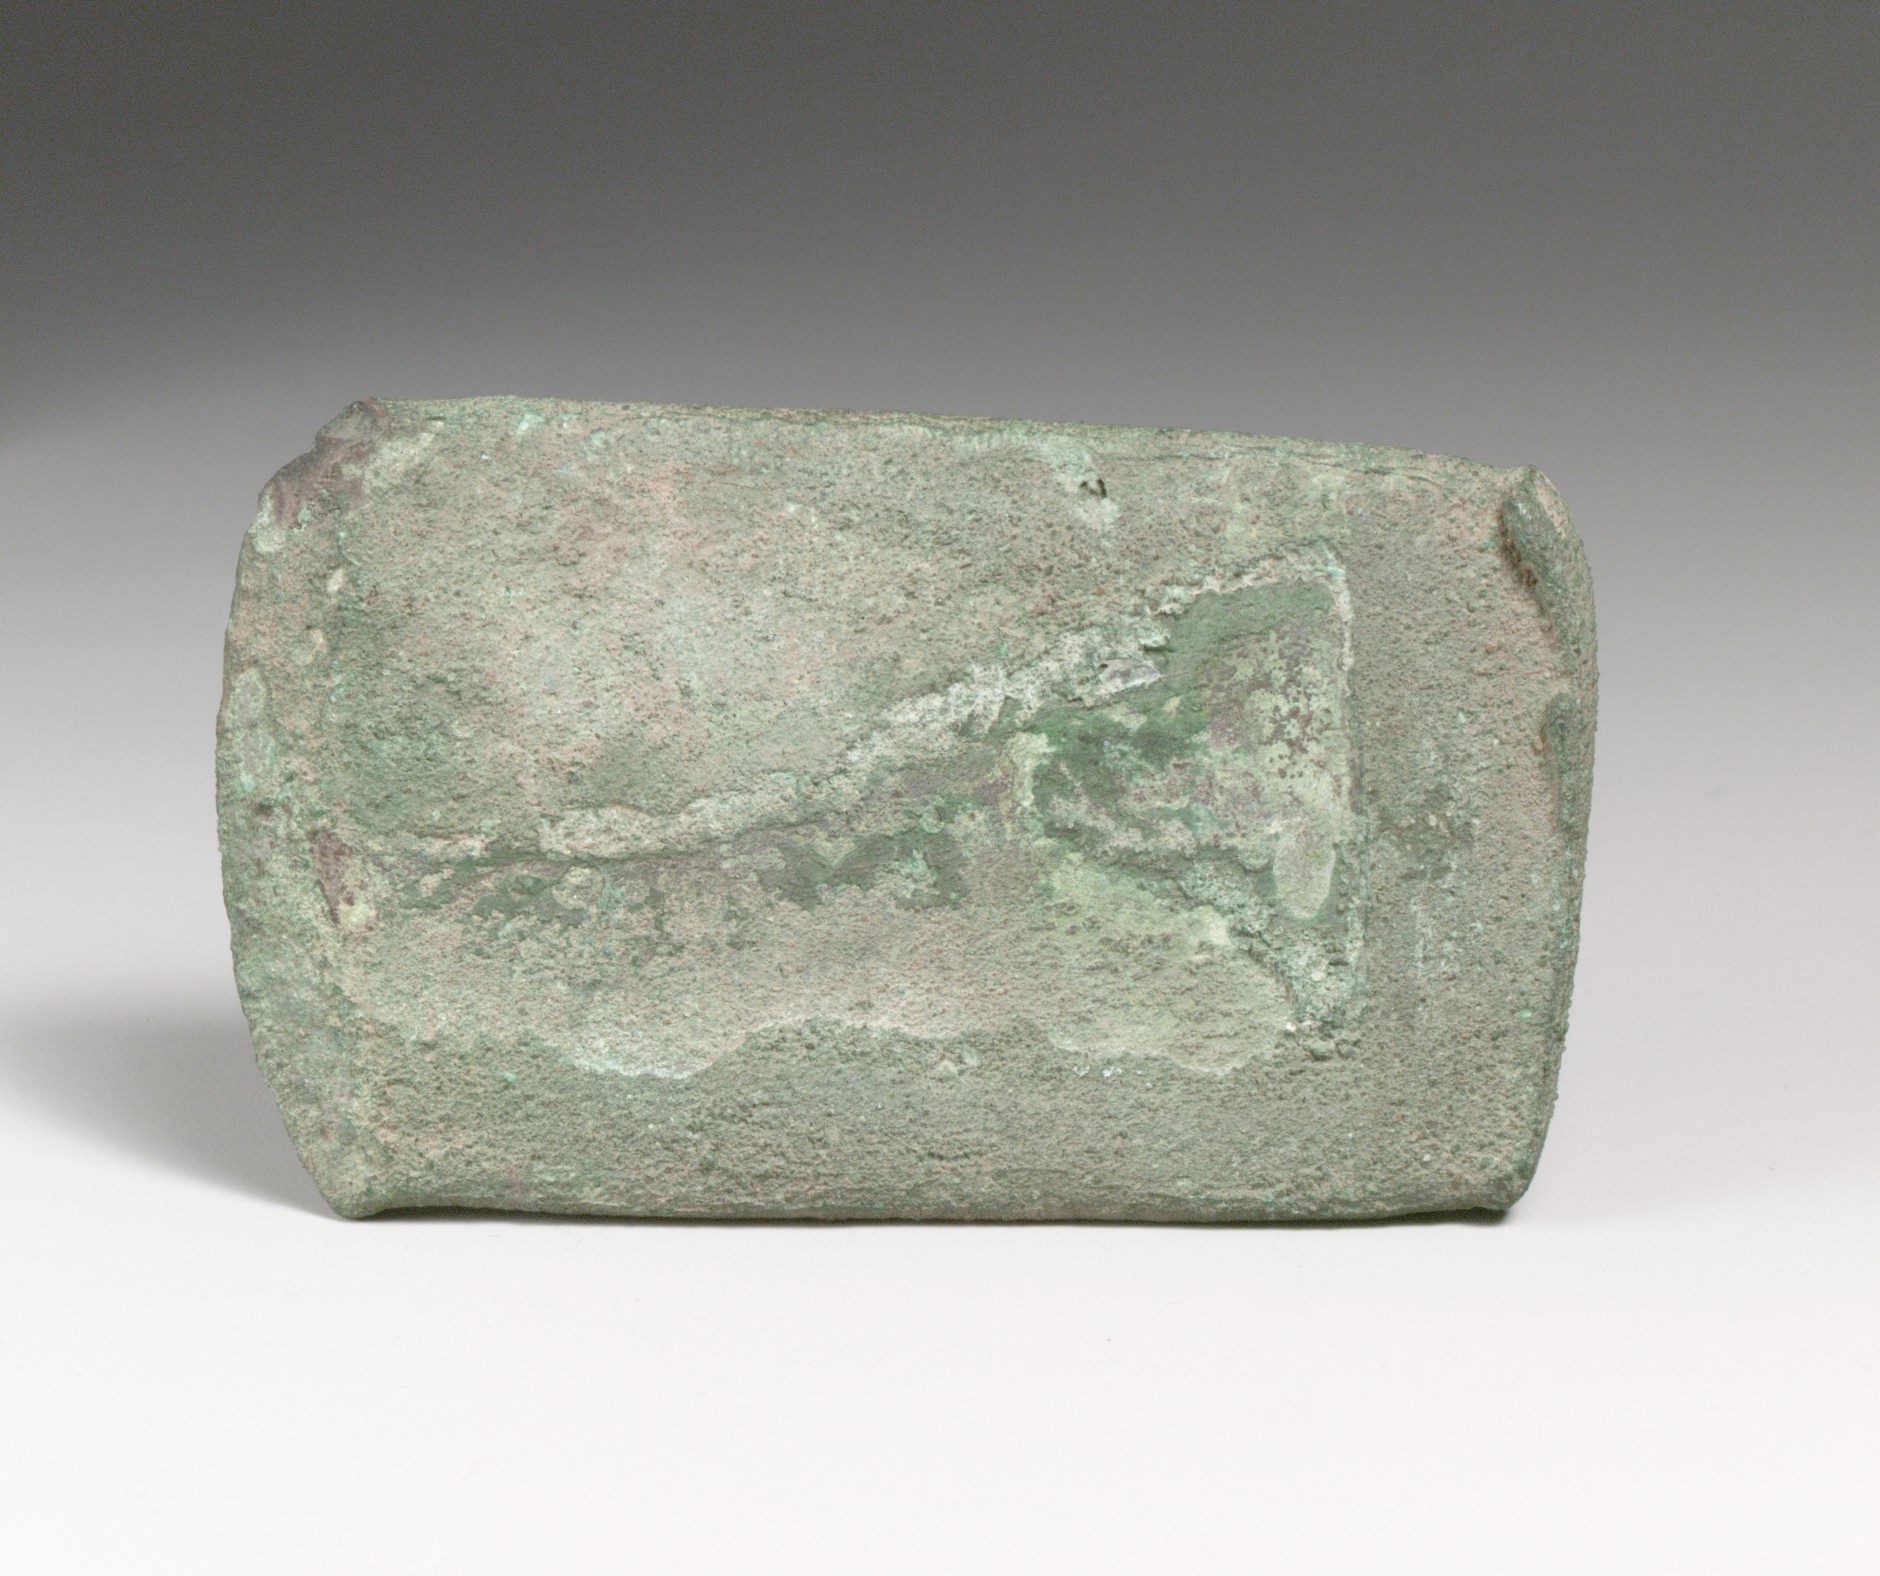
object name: axehead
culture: cypriot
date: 3900 BCE-100 CE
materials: bronze